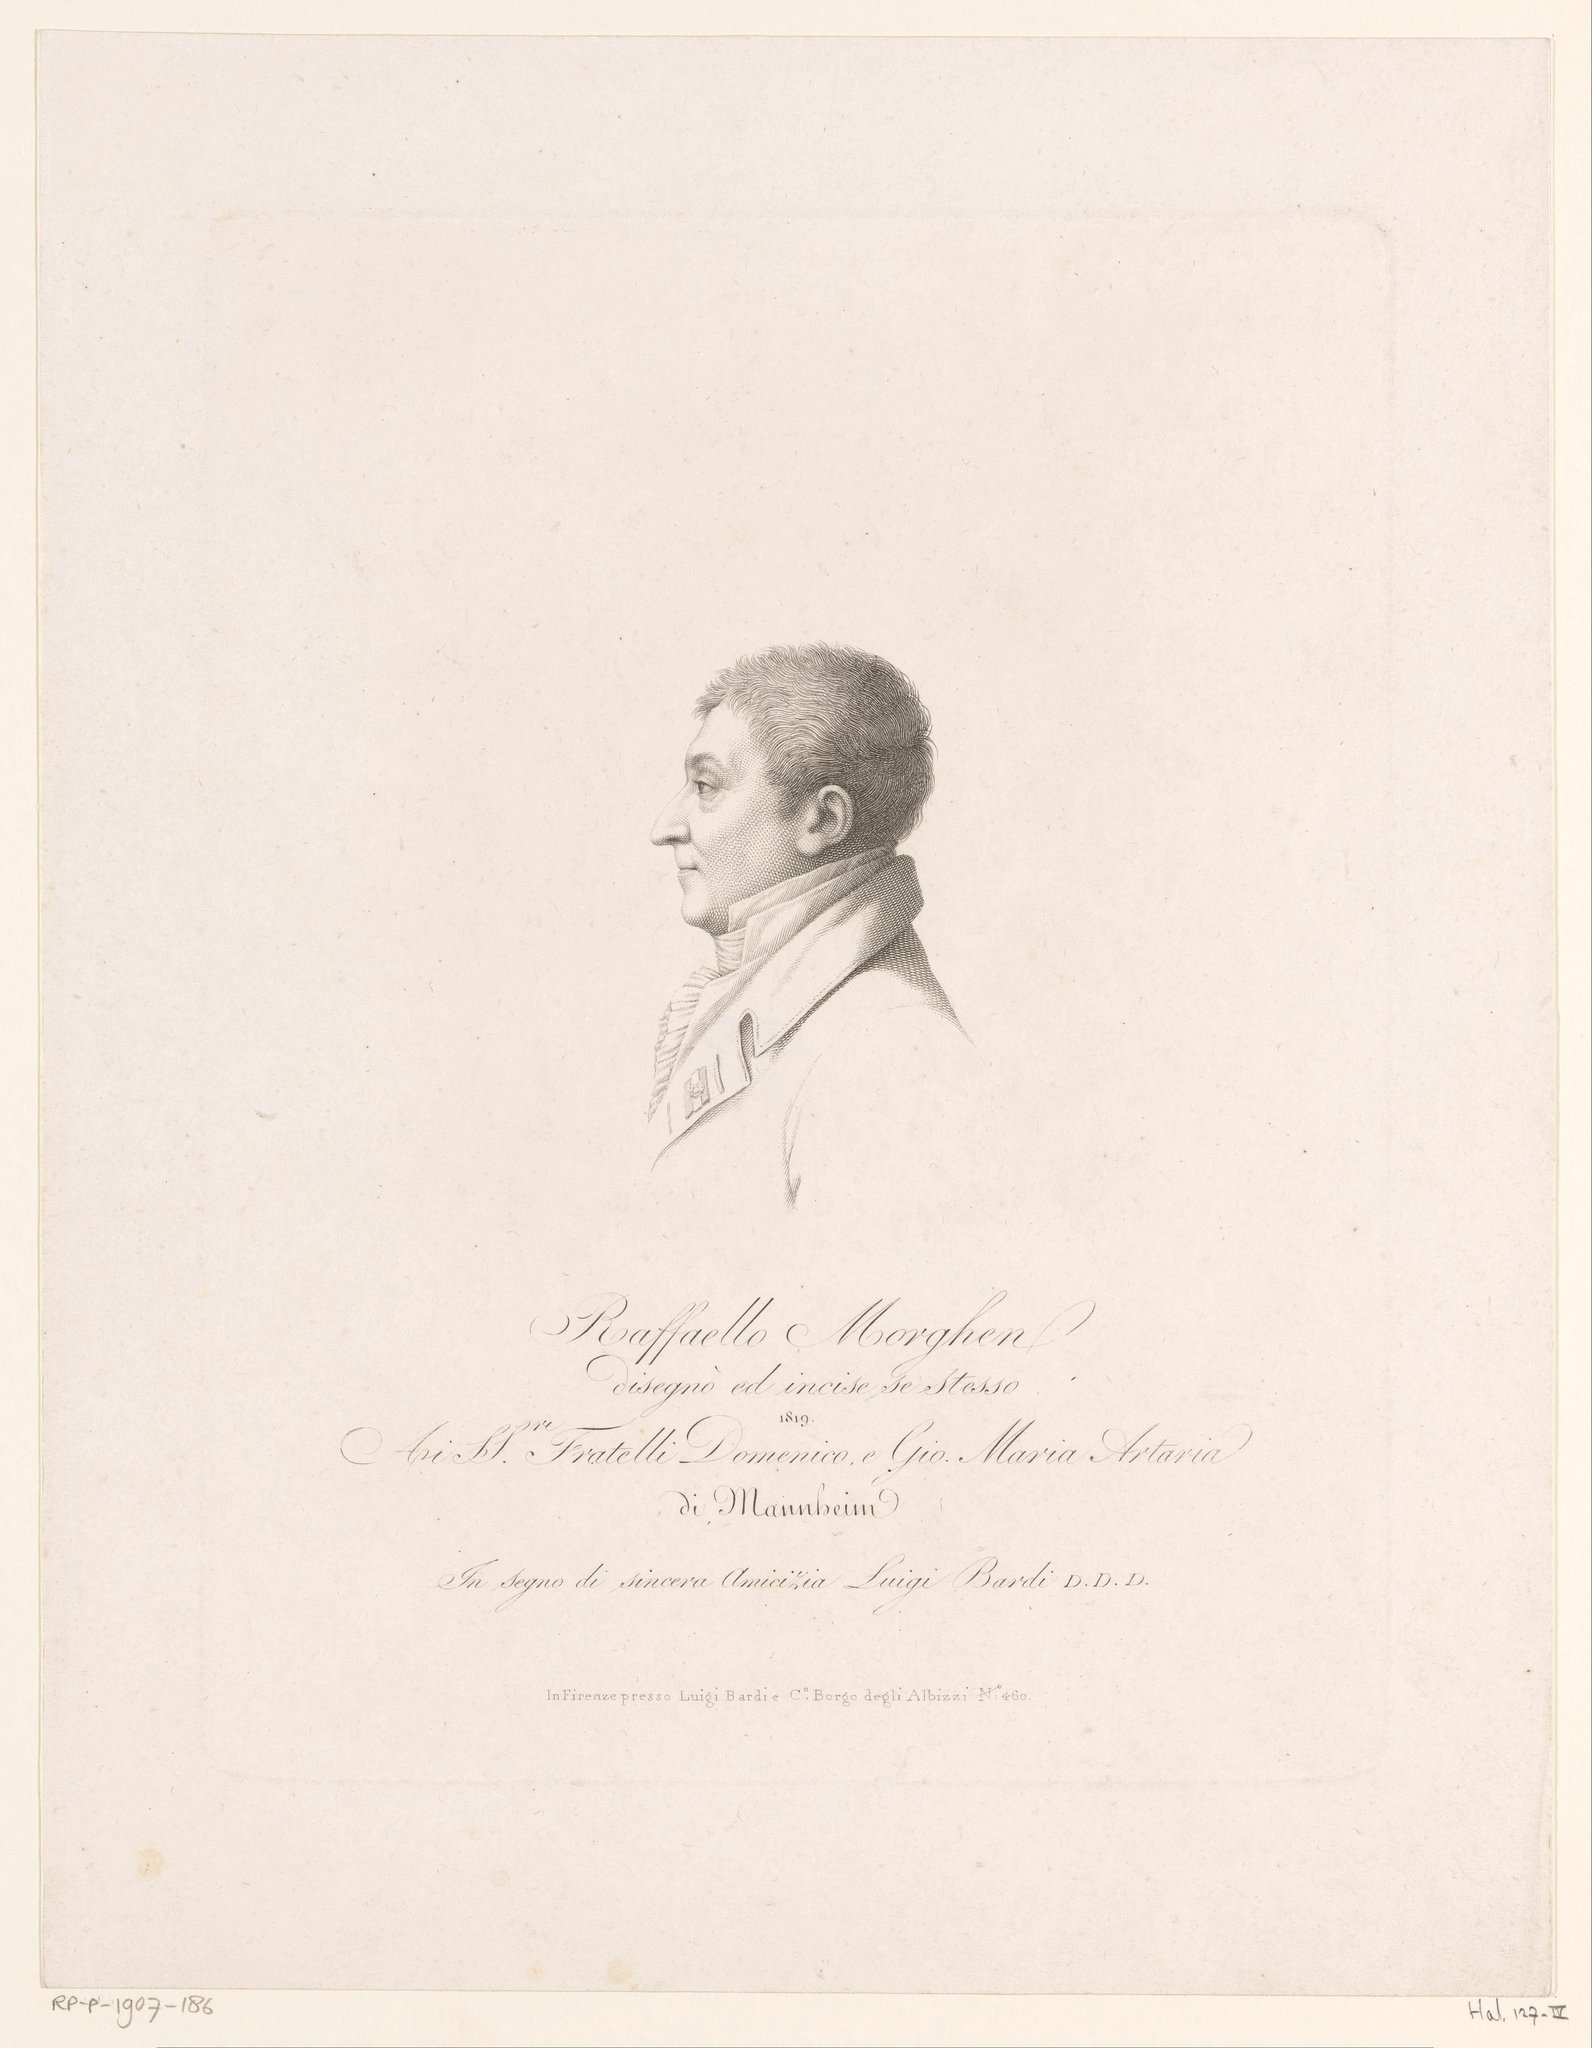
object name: print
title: Zelfportret van prentmaker Raphael Morghen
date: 1819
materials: paper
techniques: etching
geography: mannheim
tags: naples, draughtsman, raphael morghen, historical persons, portrait, self-portrait of artist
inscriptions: collector's mark: Lugt 2228